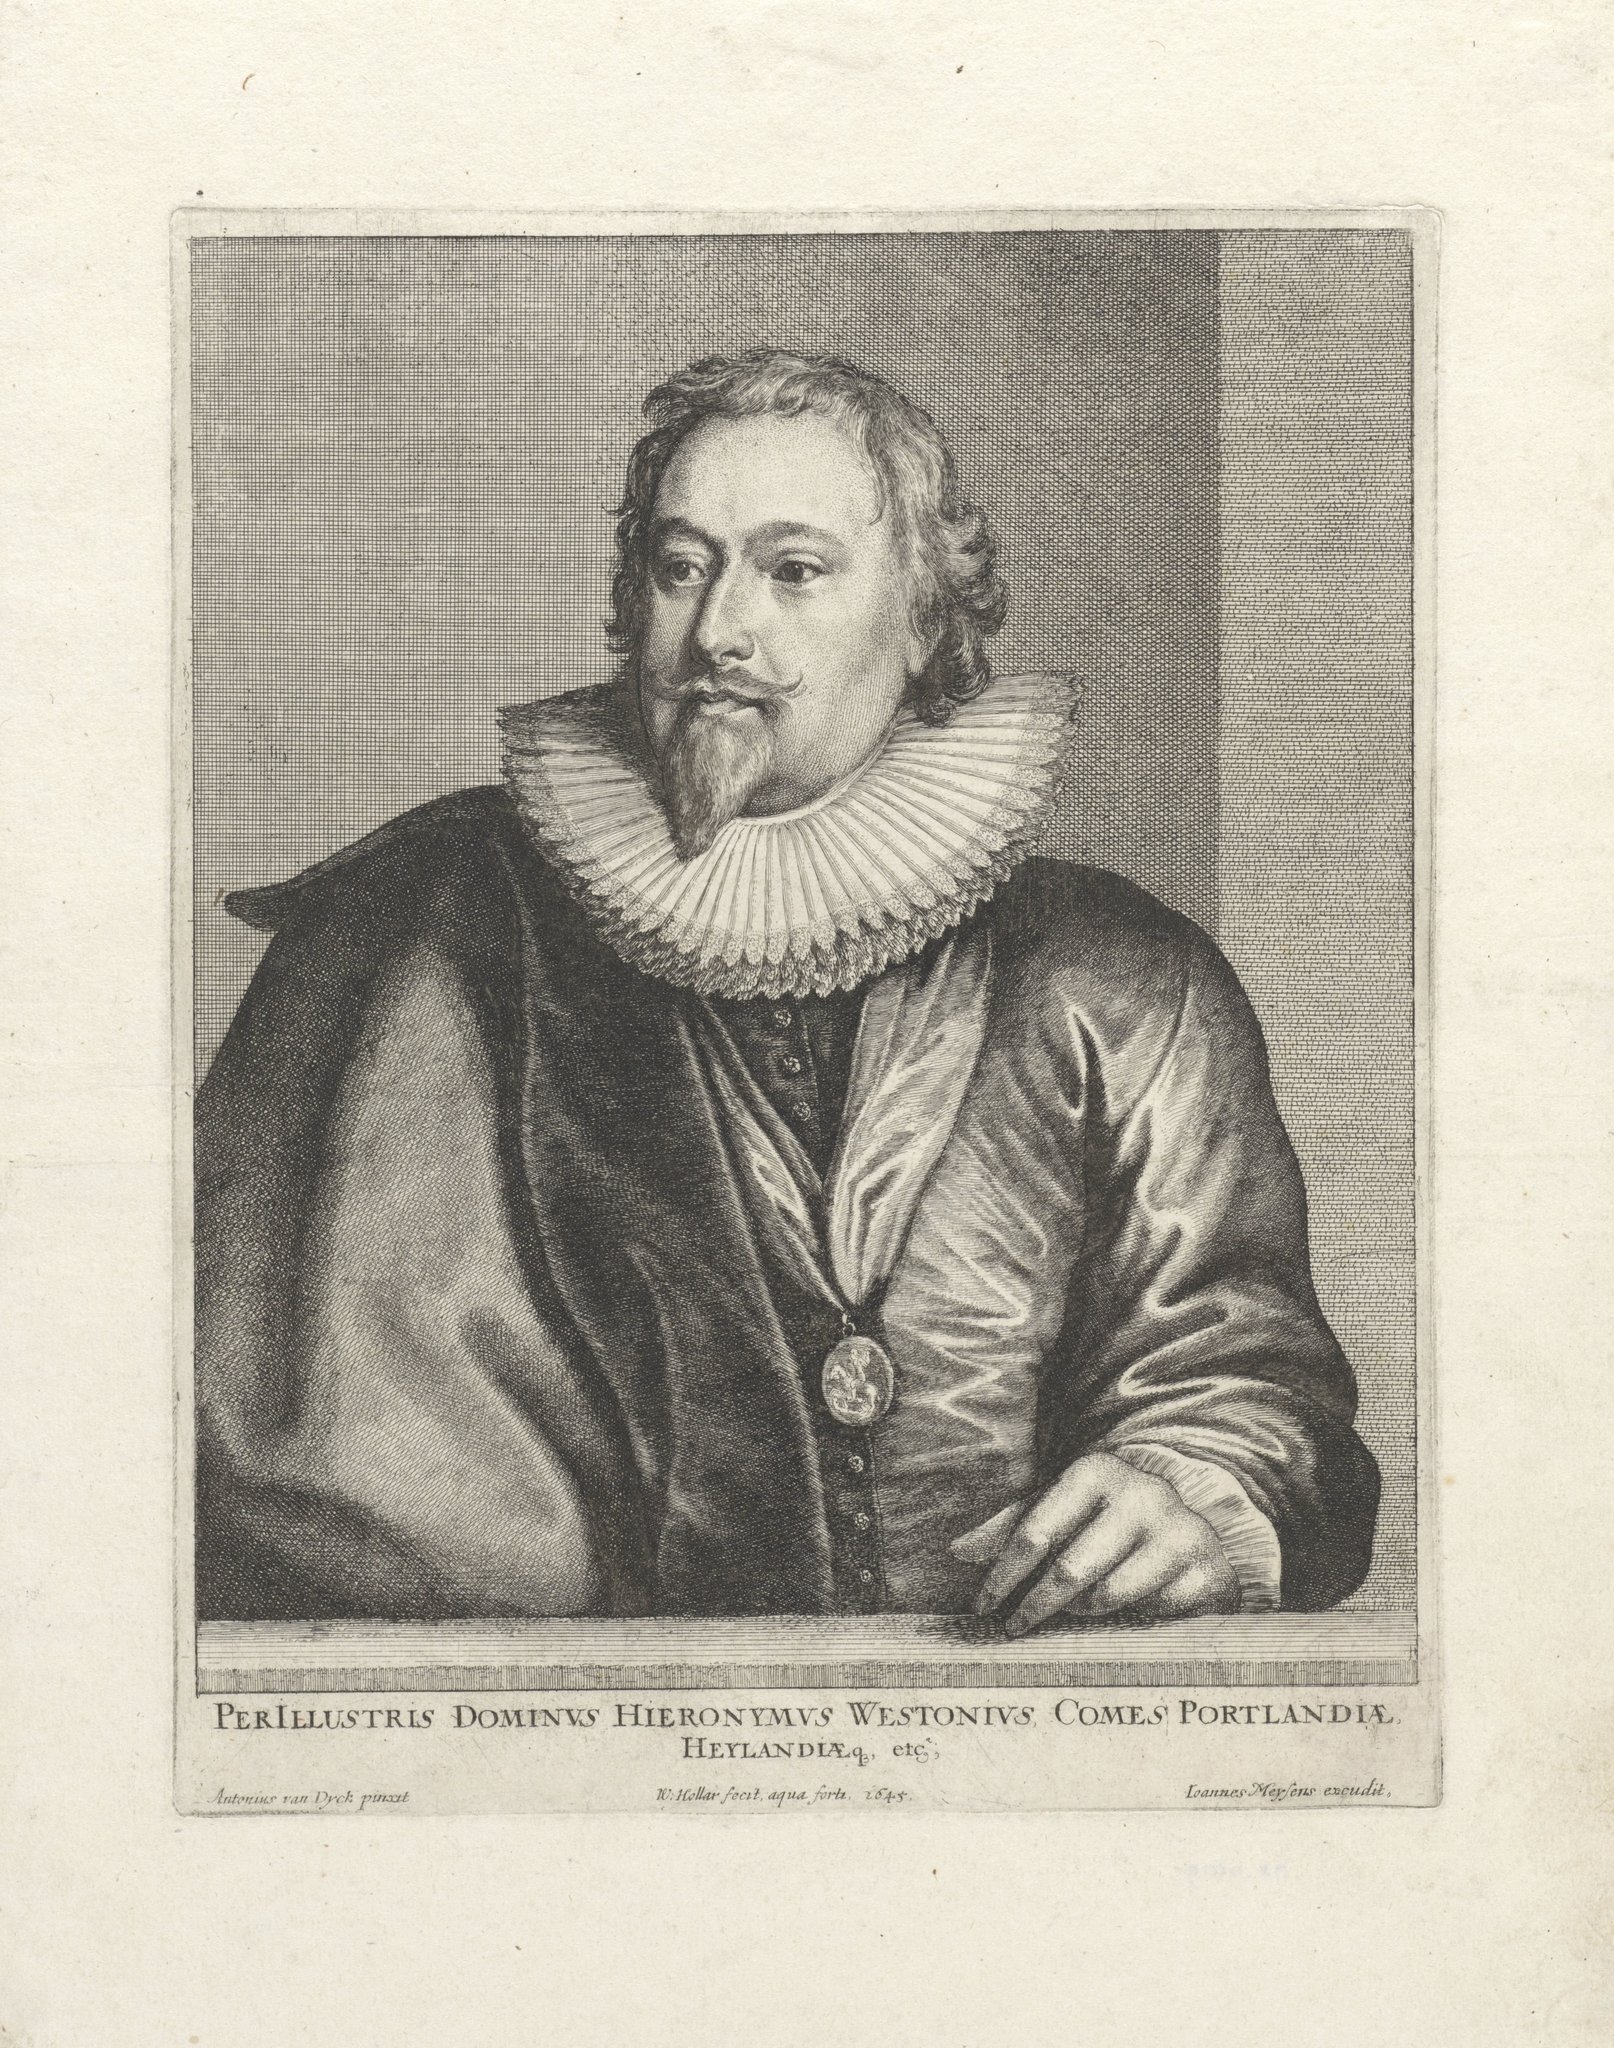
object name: print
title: Portret van Richard Weston, eerste graaf van Portland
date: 1645-1670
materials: paper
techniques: etching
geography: antwerp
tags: staatsman, richard weston (1e graaf van portland)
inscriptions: collector's mark: Lugt 240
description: De prent maakt deel uit van een zevendelige serie portretten naar Anthony van Dyck, uitgegeven door Joannes Meyssens.